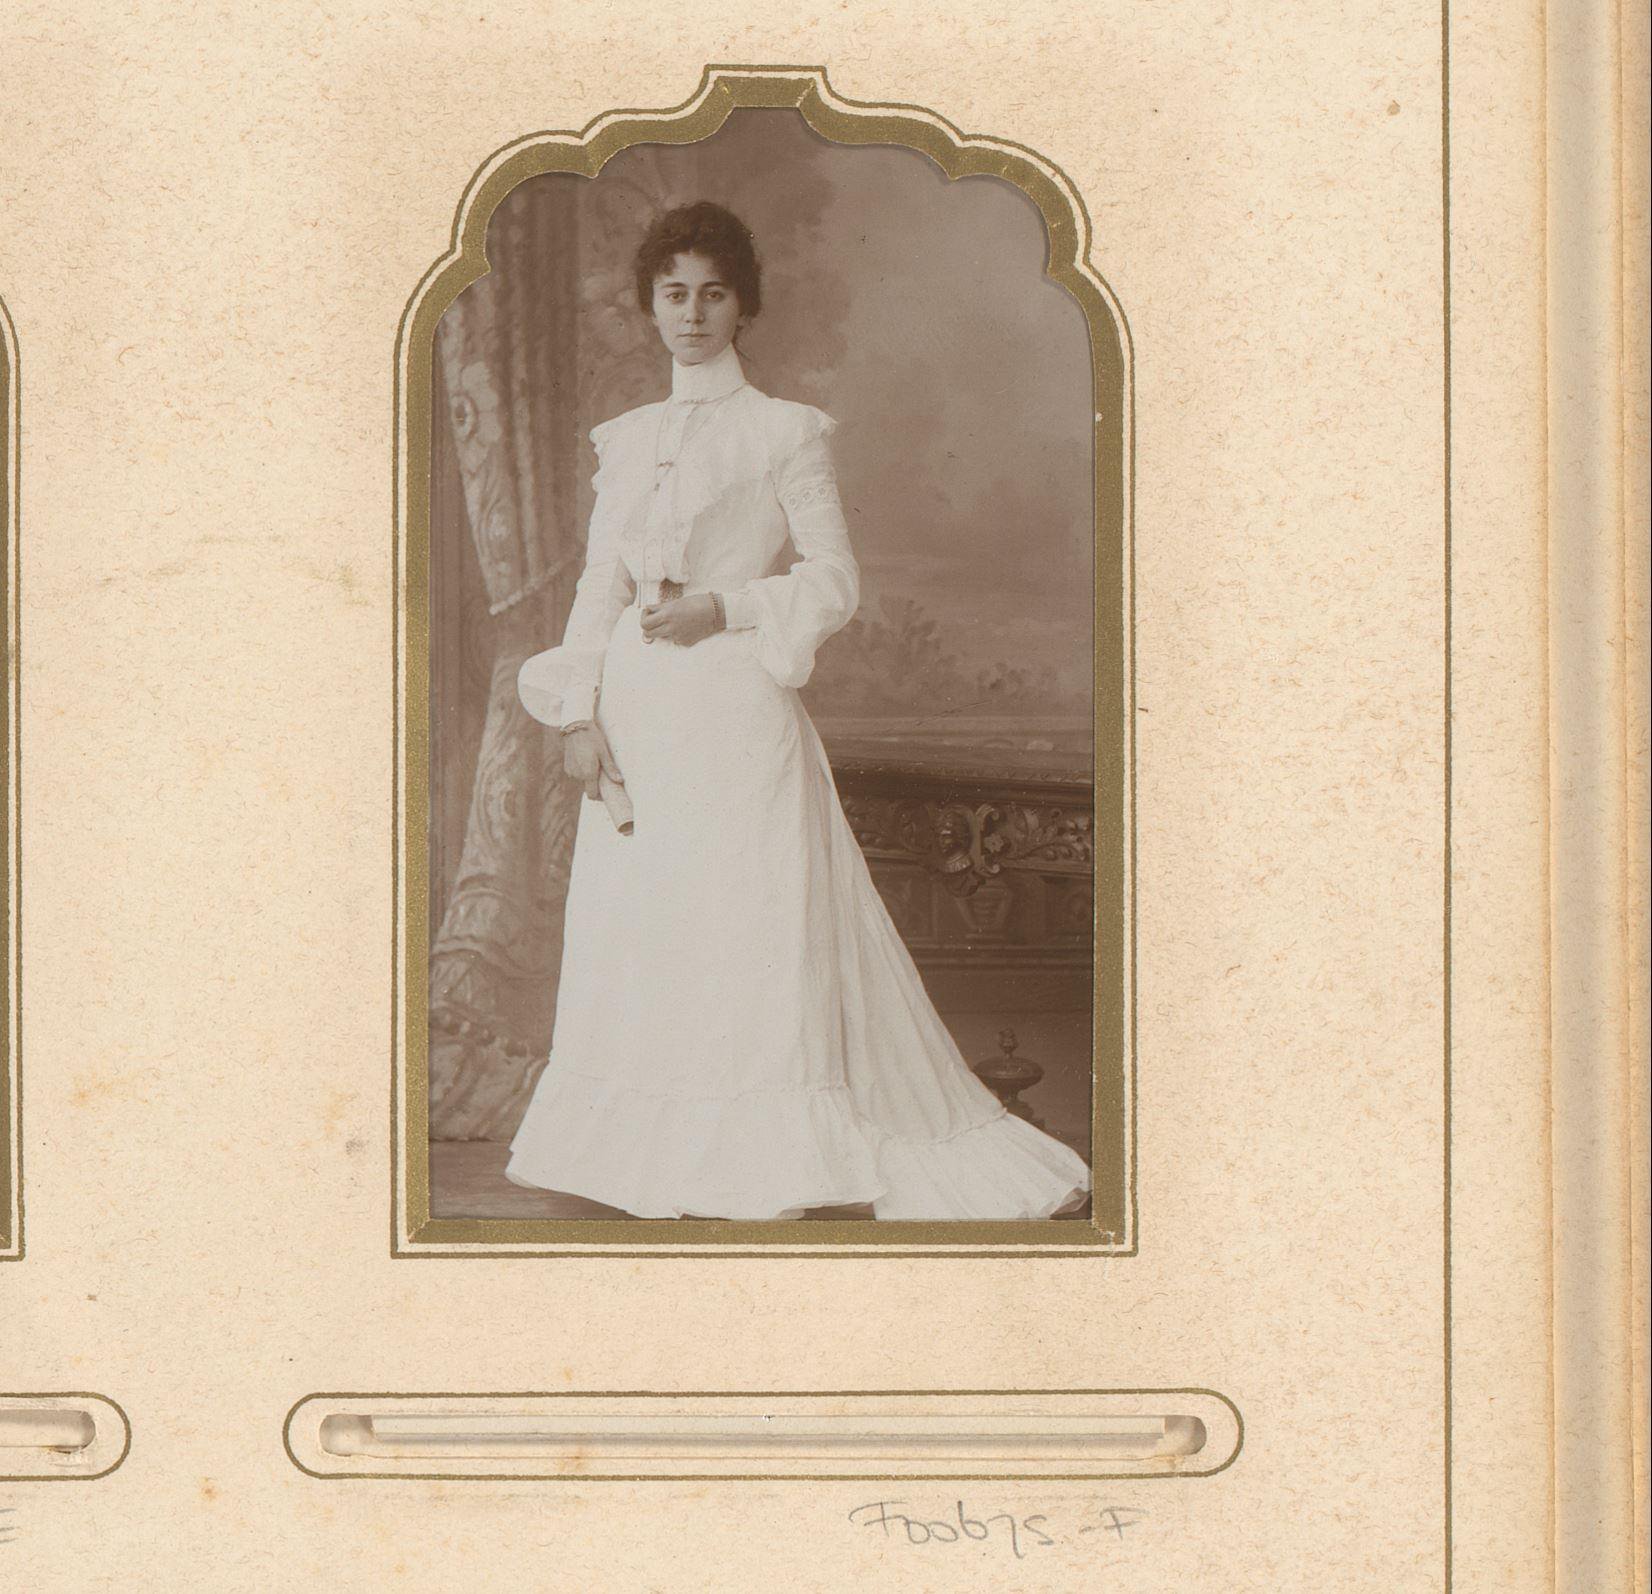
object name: carte de visite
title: Portret van een staande vrouw in witte japon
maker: e. v.d. kerkhoff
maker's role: fotograaf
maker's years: 1861-1943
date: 1902-1908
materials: cardboard, photographic support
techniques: collodion silver print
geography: amsterdam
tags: historical persons - bb - woman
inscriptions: inscription: ‘Atelier/ E.v.d. Kerkhoff/ Amsterdam/ Keizersgracht 455 (...)’